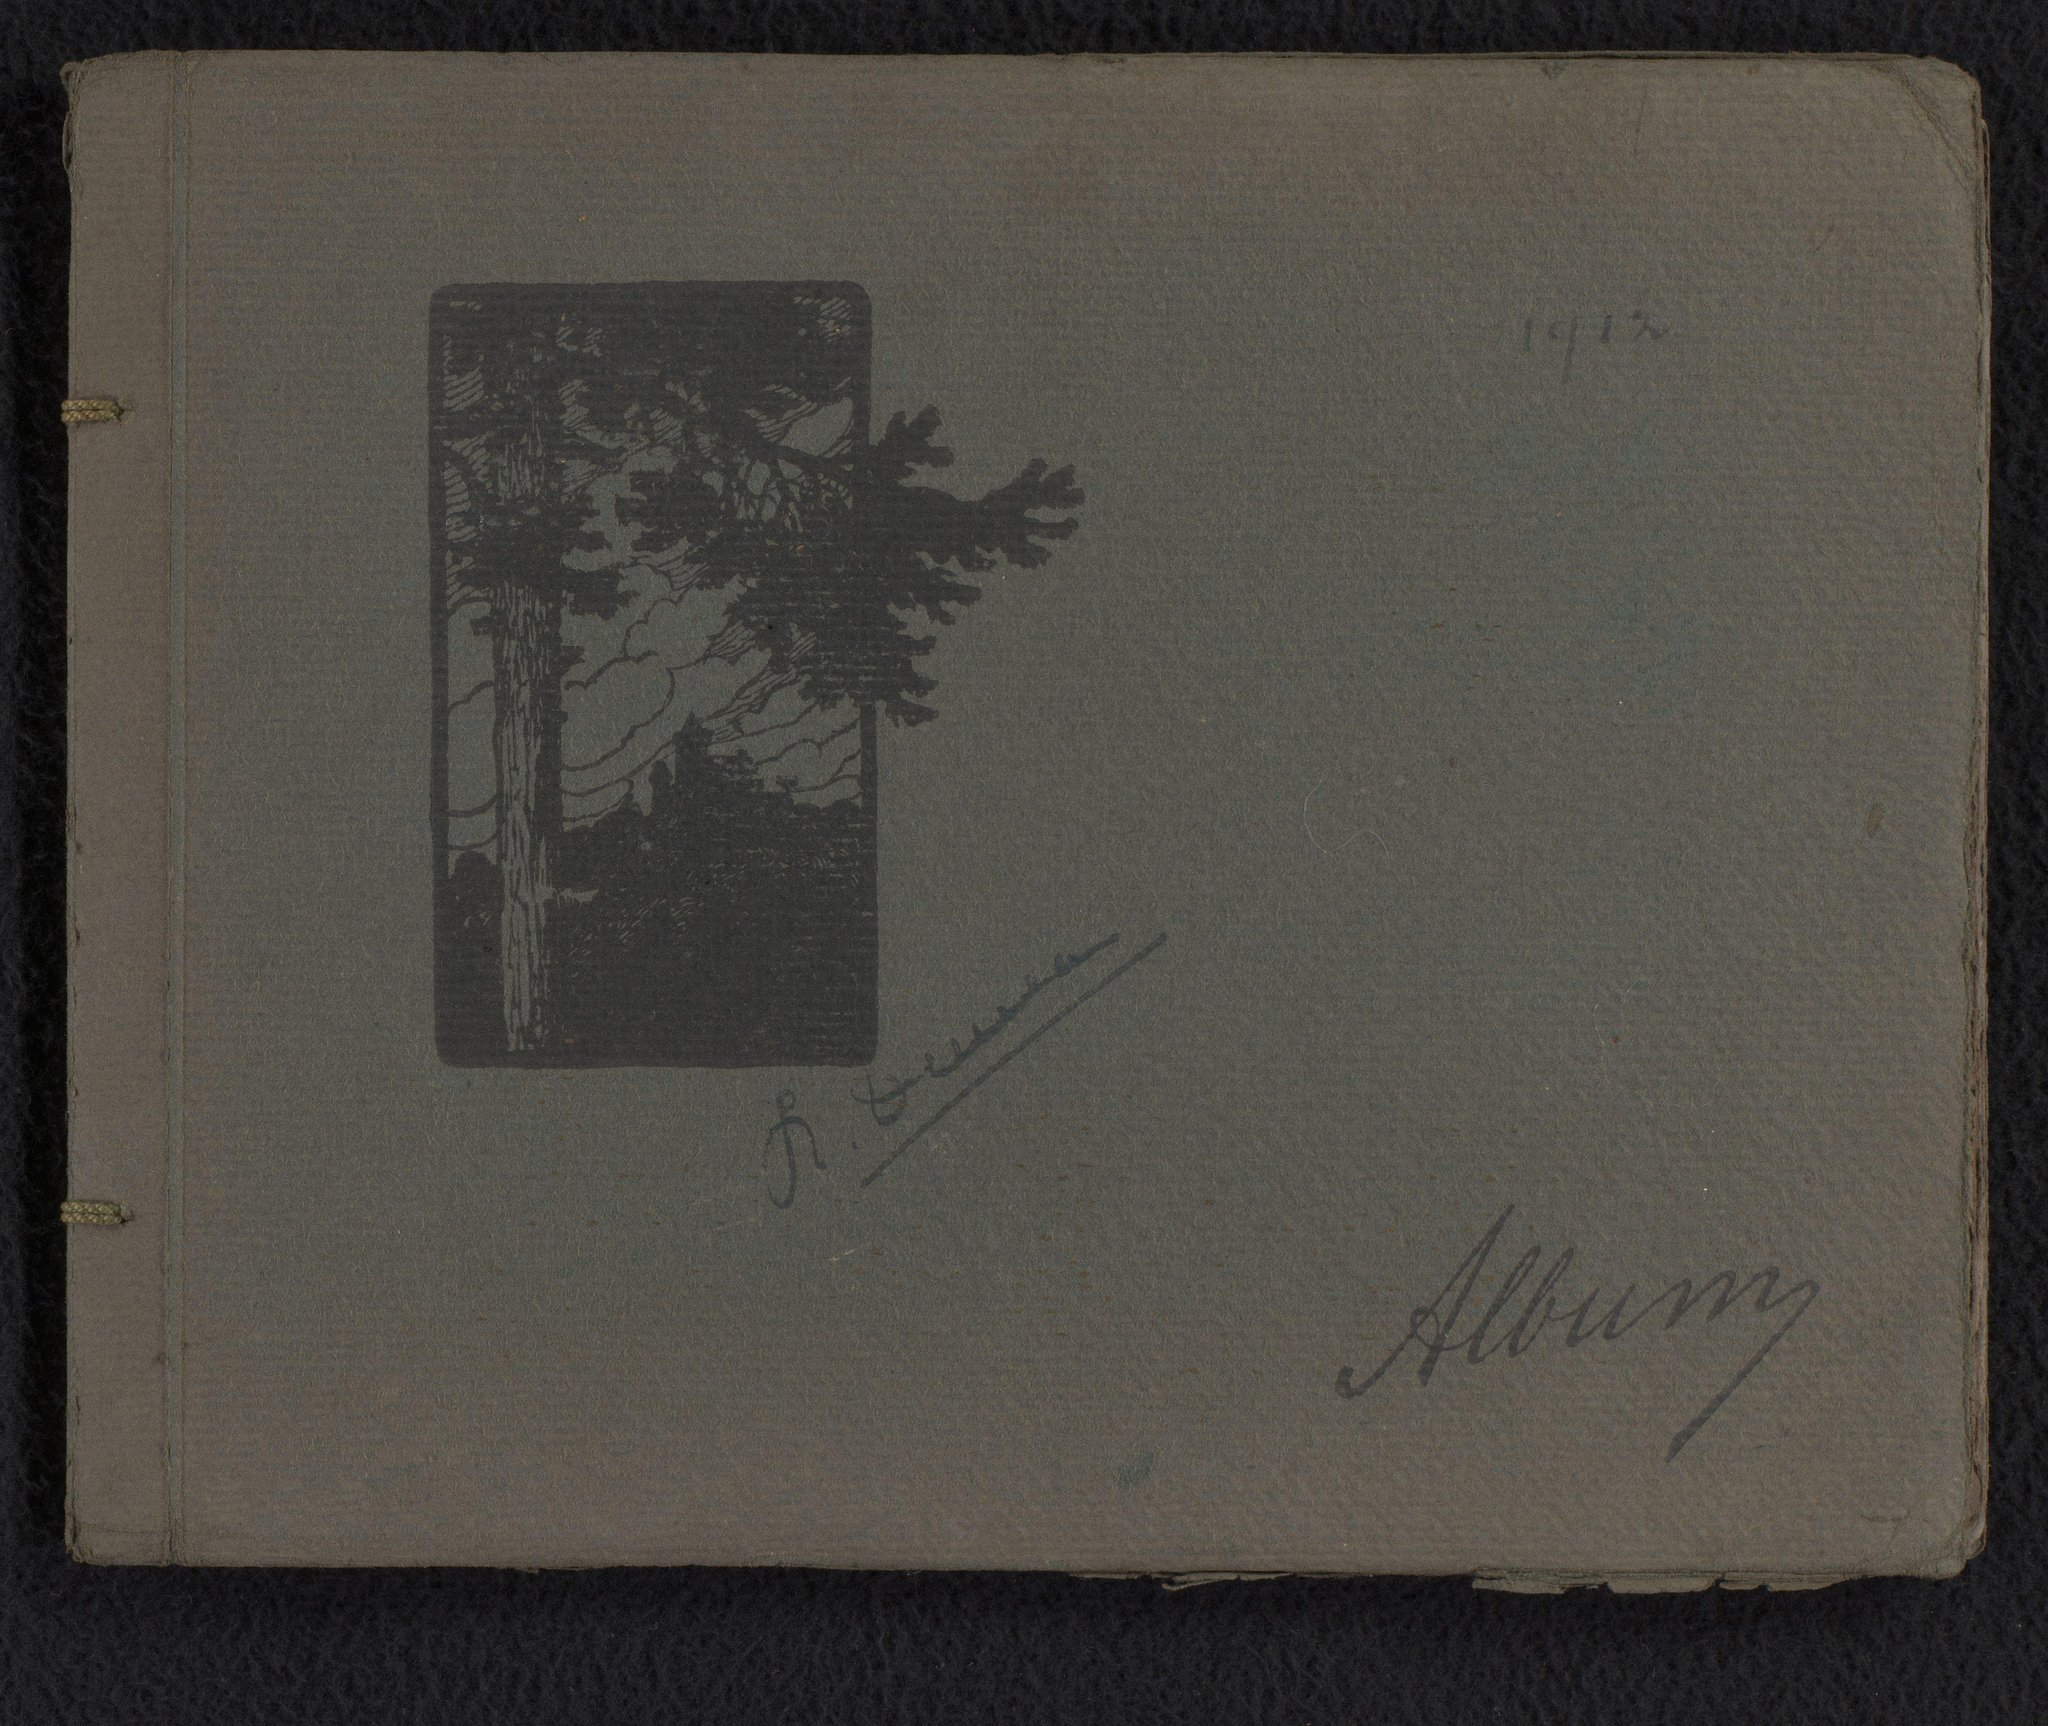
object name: photograph album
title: Fotoalbum van Carolina (Loentje) Onnen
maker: carolina frederika onnen (lien/loen)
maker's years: 1896-1983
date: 1912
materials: paper, cardboard, fiber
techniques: collodion silver print, gelatin silver print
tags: batavia, emilie albertina onnen (milly), carolina frederika onnen (lien/loen), friends, brussels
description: Fotoalbum van Carolina (Loentje) Onnen met 61 foto's op 23 bladen.